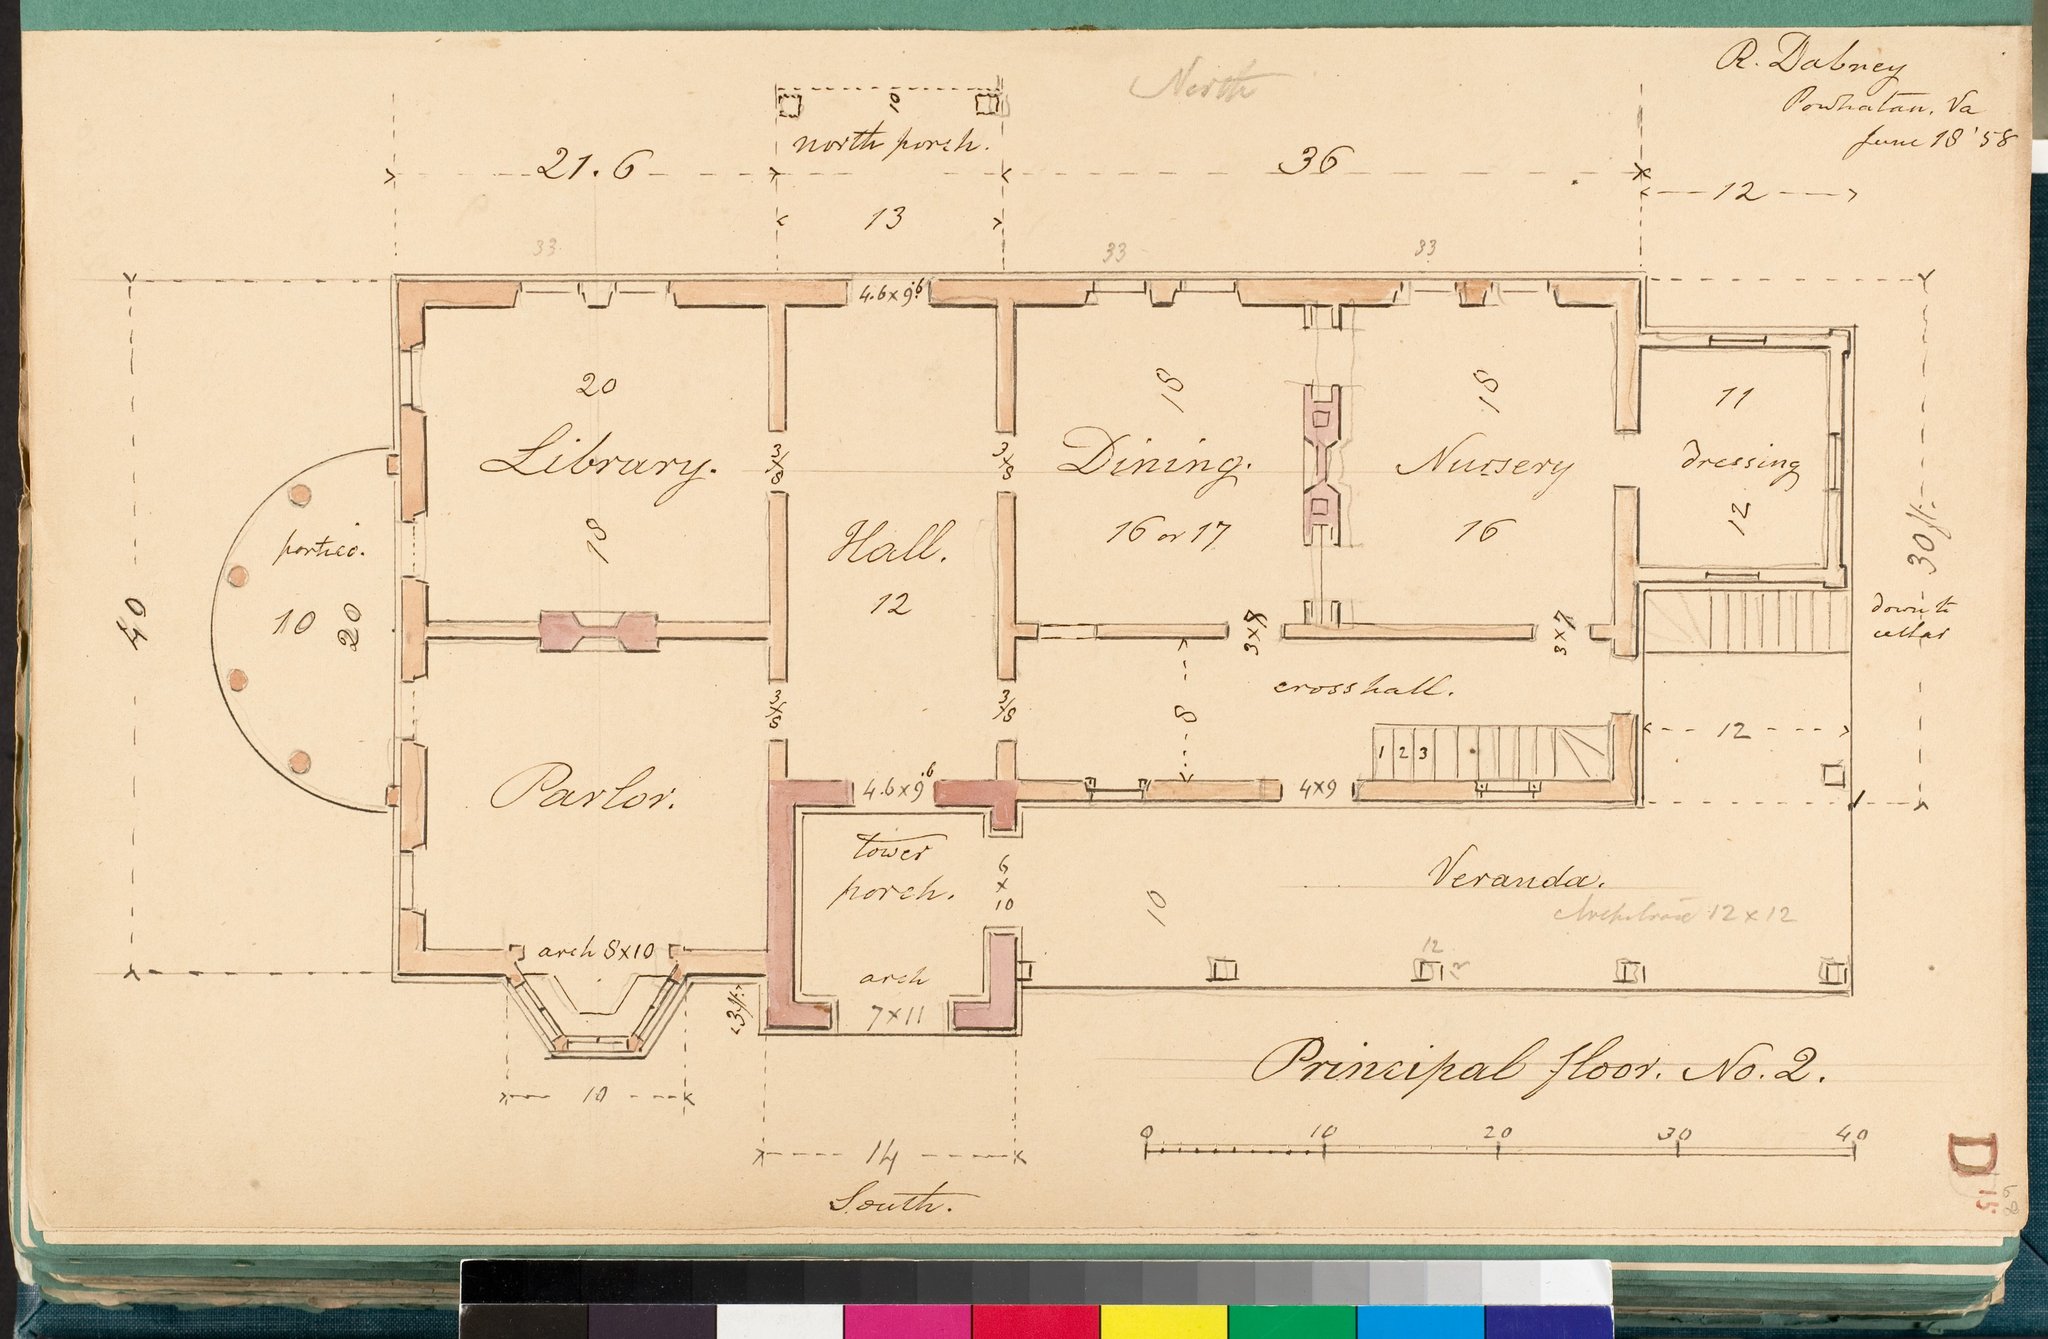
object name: drawing ornament architecture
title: House for R. Dabney, Powhatan, Virginia (plan of principal floor)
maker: alexander jackson davis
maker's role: artist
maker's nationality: american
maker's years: 1803-1892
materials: ink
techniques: wash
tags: architecture